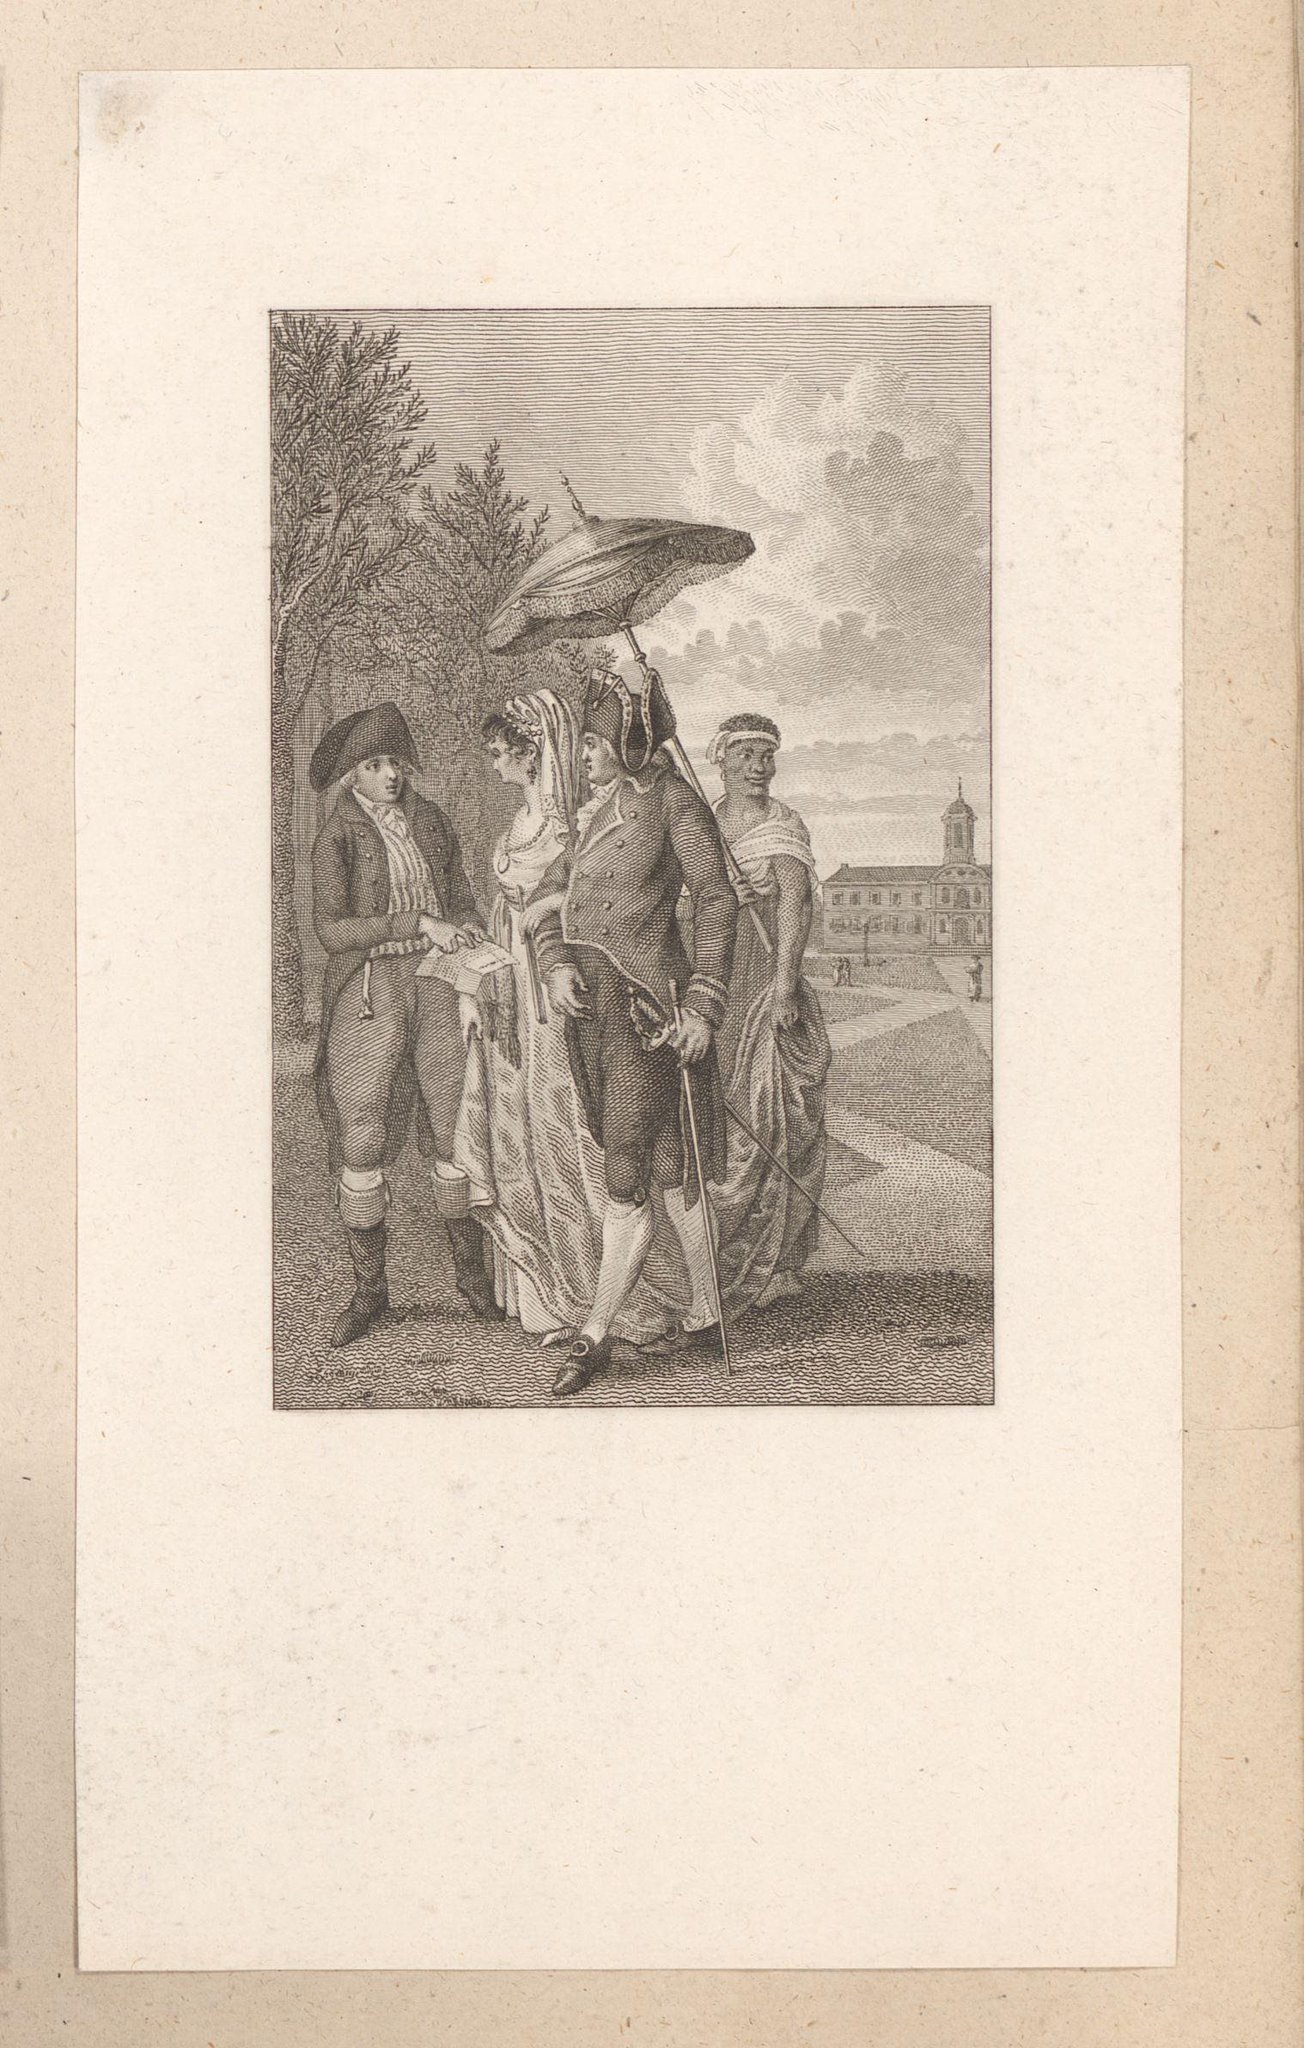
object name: album leaf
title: Jakob en Hidde voeren een gesprek tijdens een wandeling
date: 1804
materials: paper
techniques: engraving, etching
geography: amsterdam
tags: garden, letter, envelope, conversation, dialogue; conversation piece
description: Tijdens een wandeling vertelt Jakob ten Haaf aan Hidde dat hij terug zal gaan naar zijn Vaderland. Hij laat daarbij de brief van zijn vader zien. De prent maakt deel uit van een album.